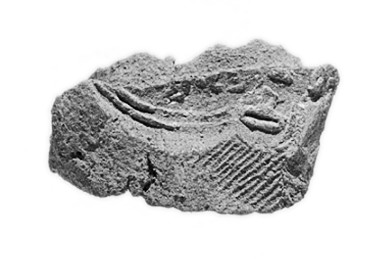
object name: sealing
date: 1981-1640 BCE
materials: mud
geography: egypt